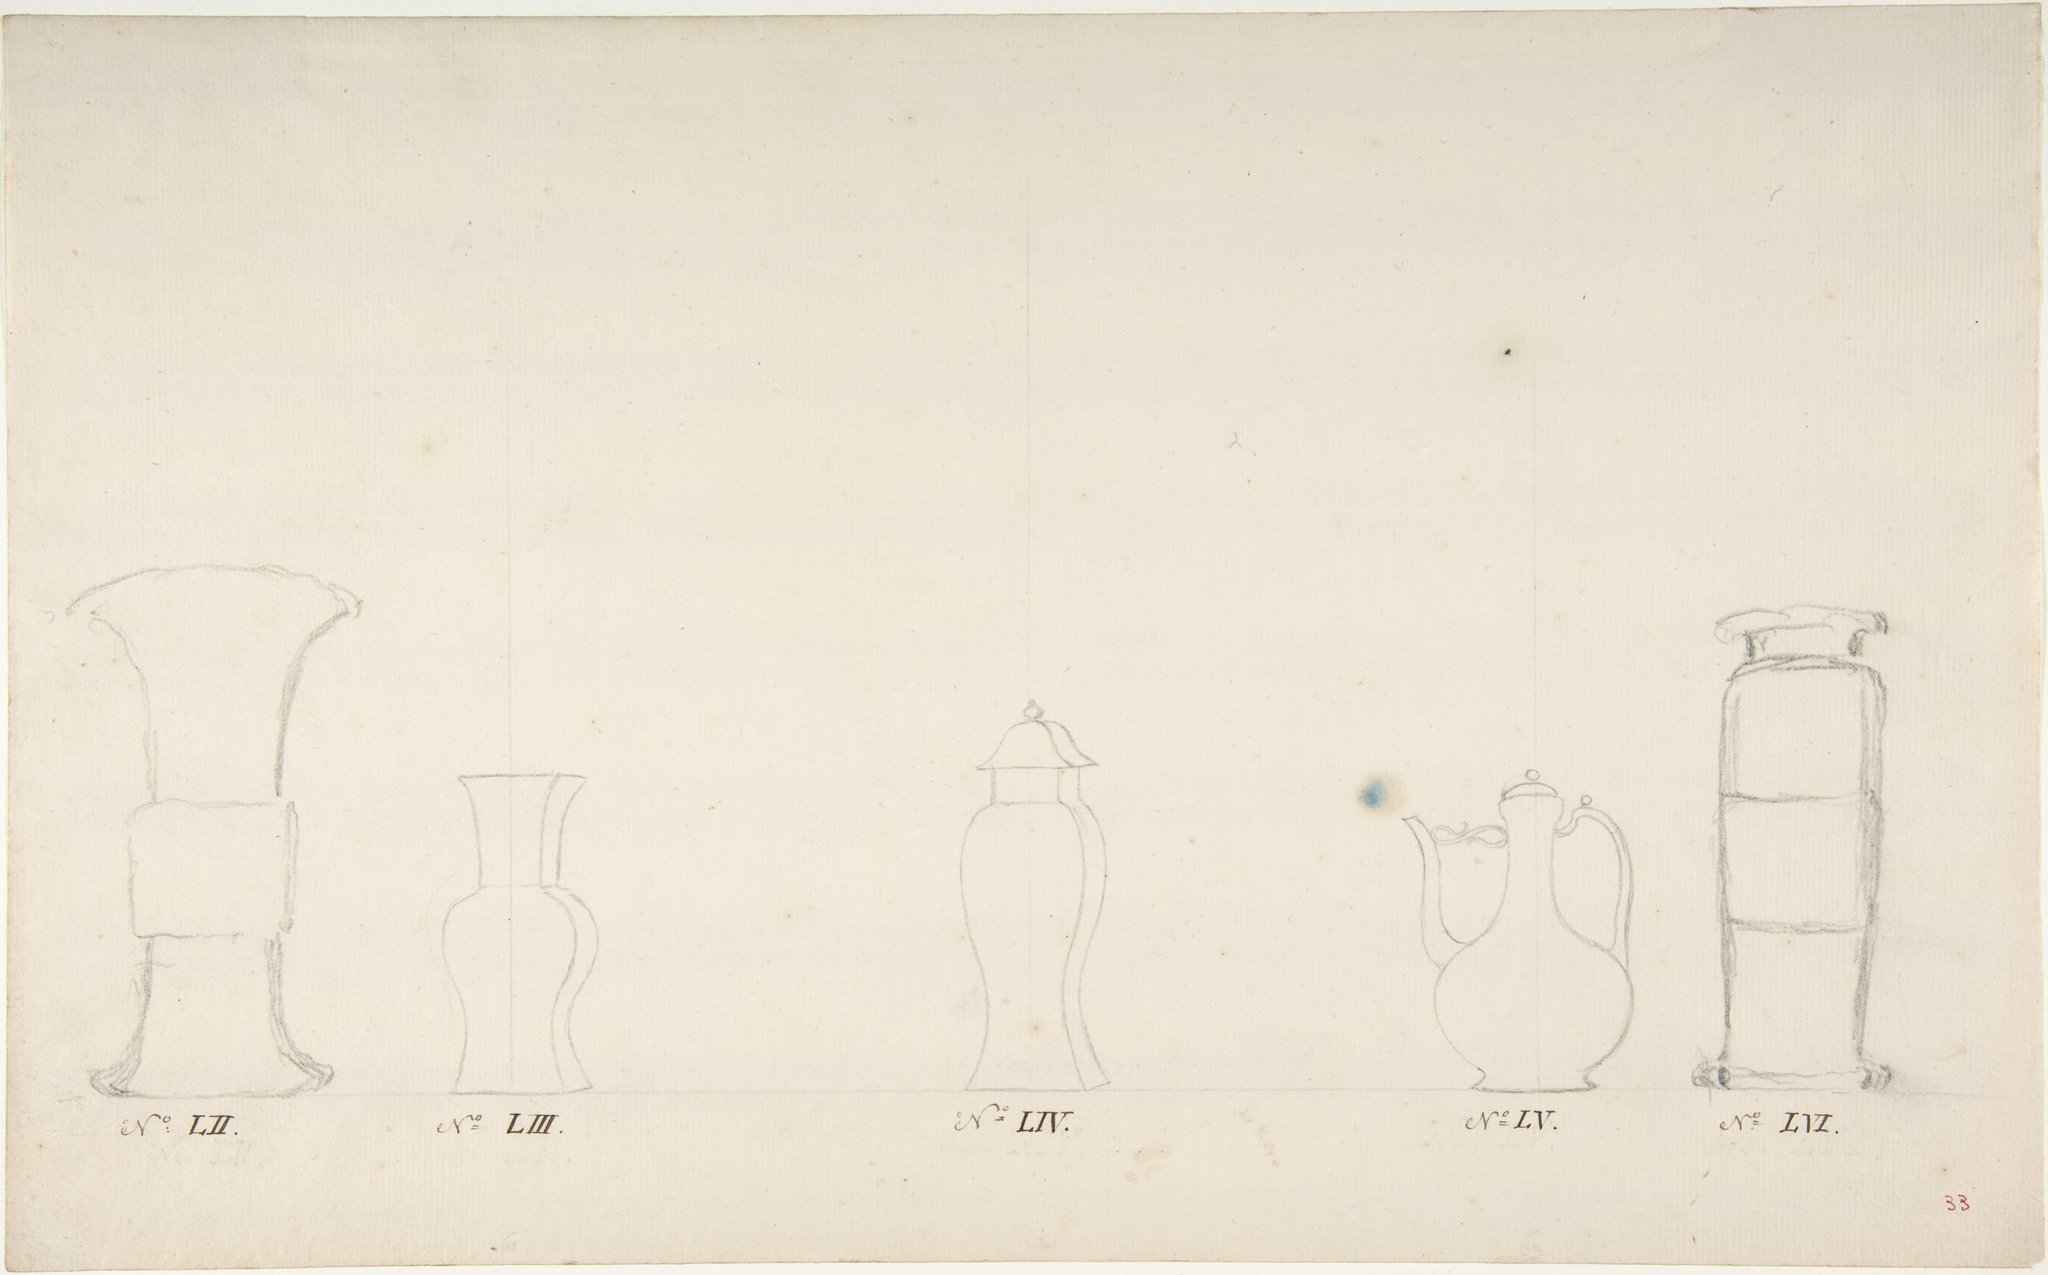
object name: drawing ornament architecture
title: Design for Four Vases and a Teapot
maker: anonymous, french, 18th century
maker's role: artist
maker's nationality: french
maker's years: 1700-1800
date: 1770-1785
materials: chalk, ink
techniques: pen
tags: teapots,vases